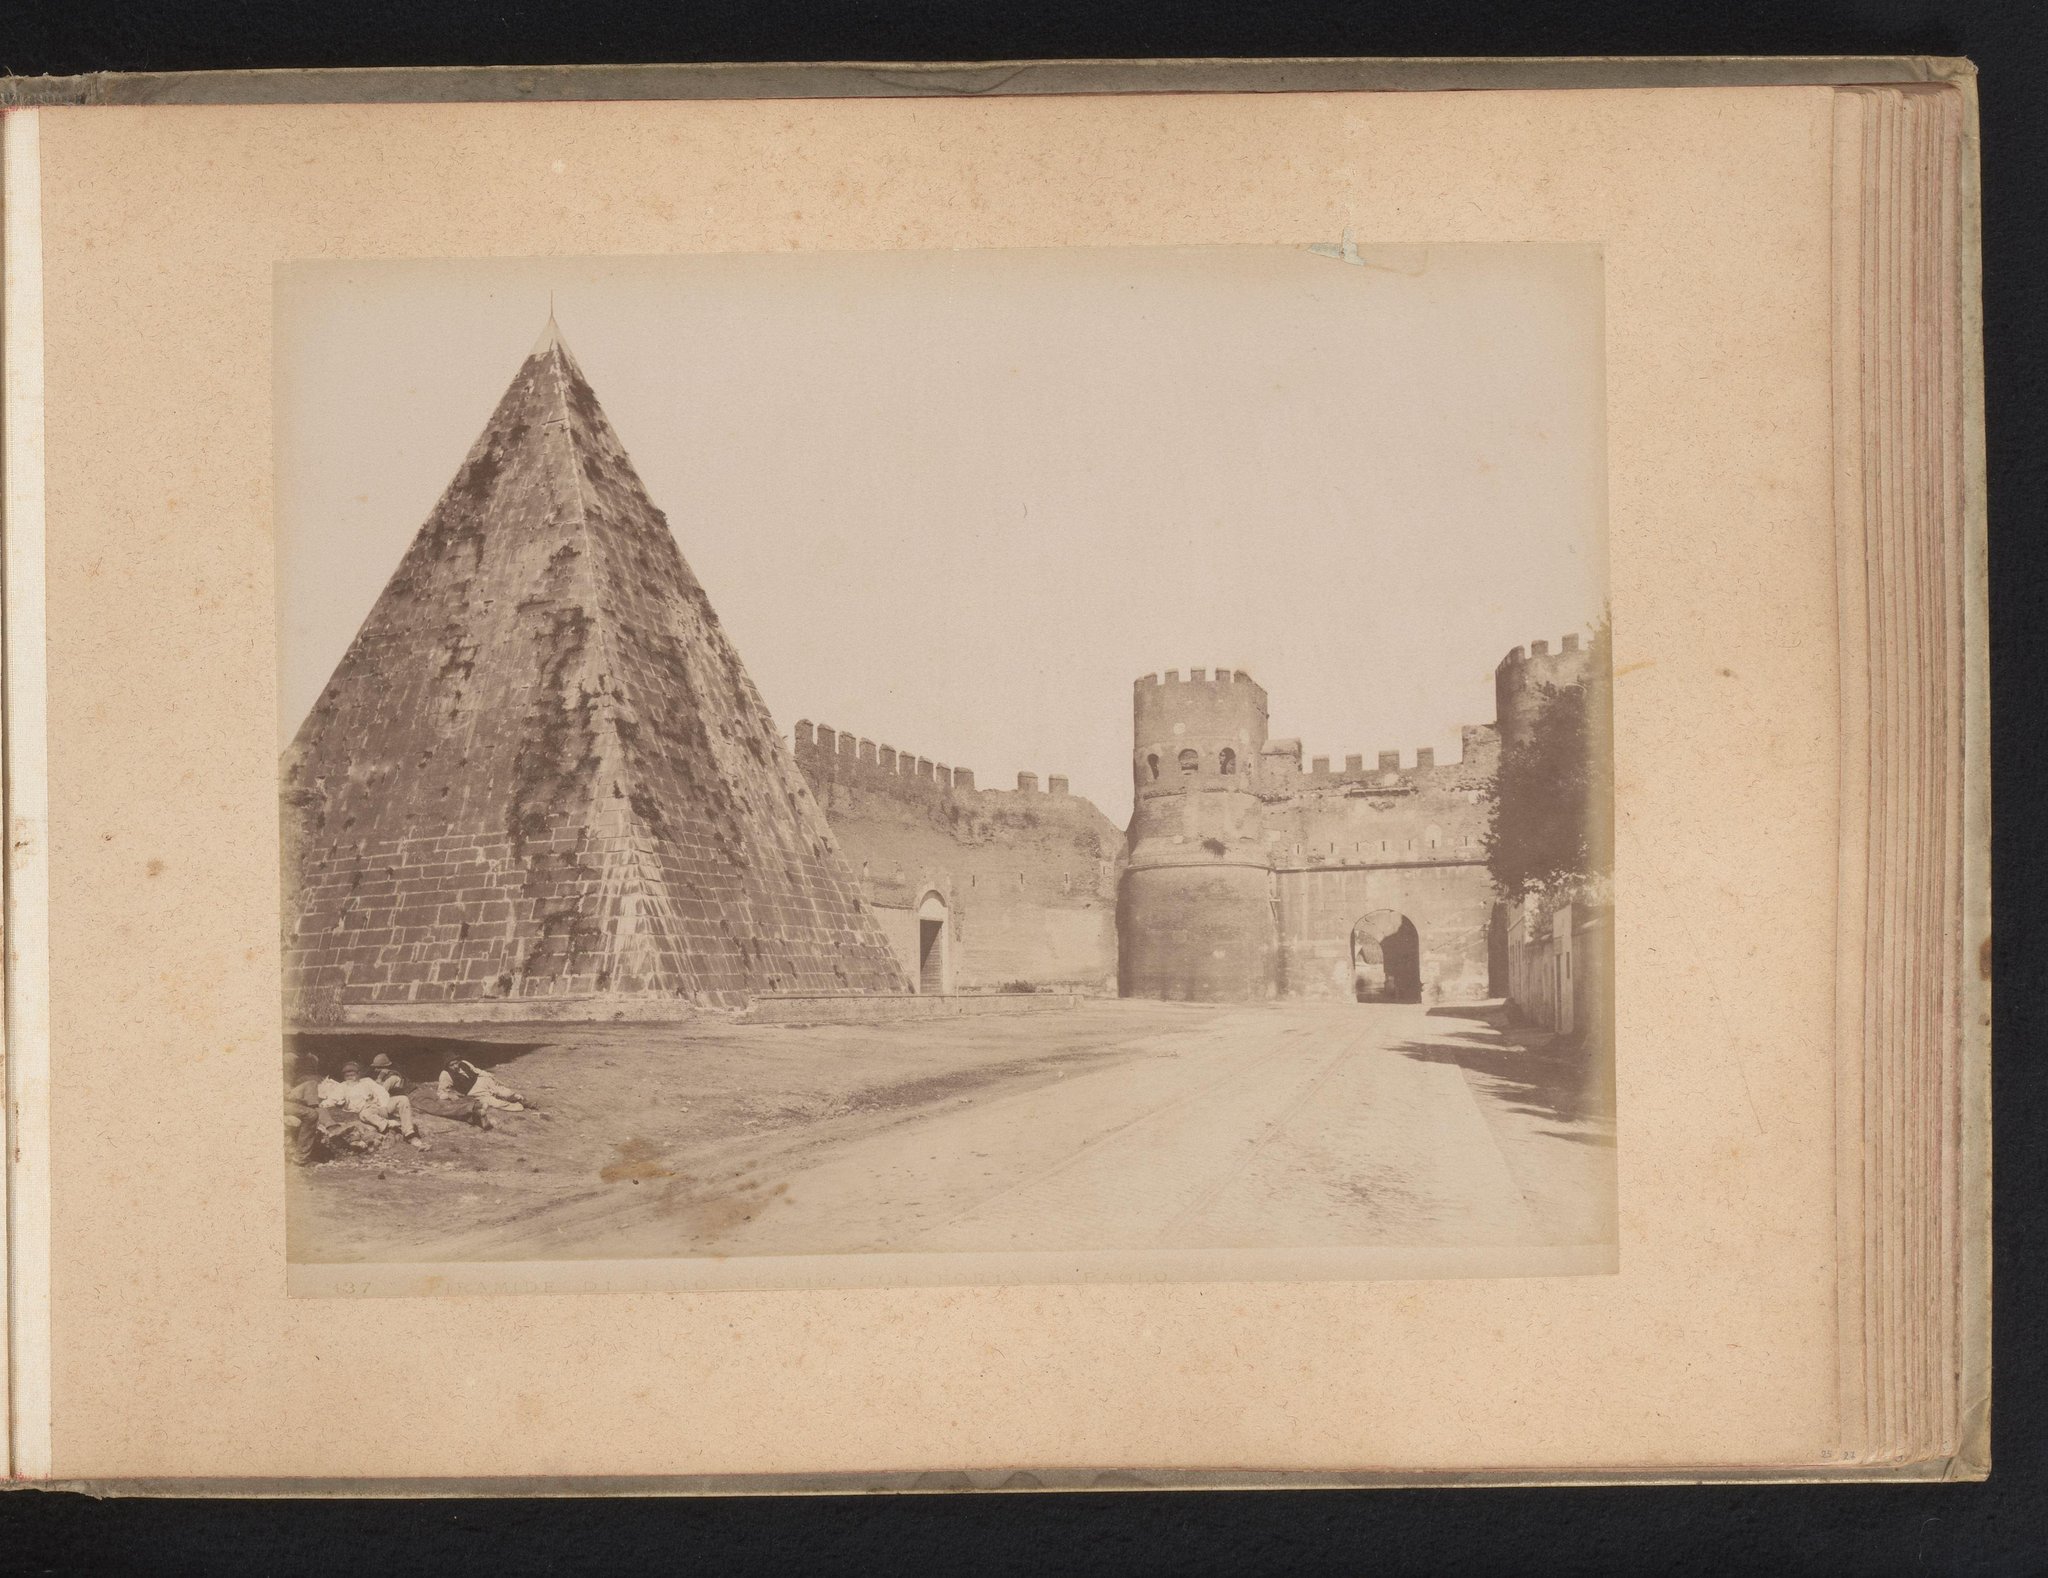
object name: album leaf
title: Gezicht op de Piramide van Cestius en de Porta San Paolo in Rome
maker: Anonymous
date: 1870-1895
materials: cardboard, photographic support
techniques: albumen print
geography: rome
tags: pyramid (marking grave), city-gate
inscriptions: inscription: ‘137 PIRAMIDE DI GAIO CESTIO CON PORTA S. PAOLO’